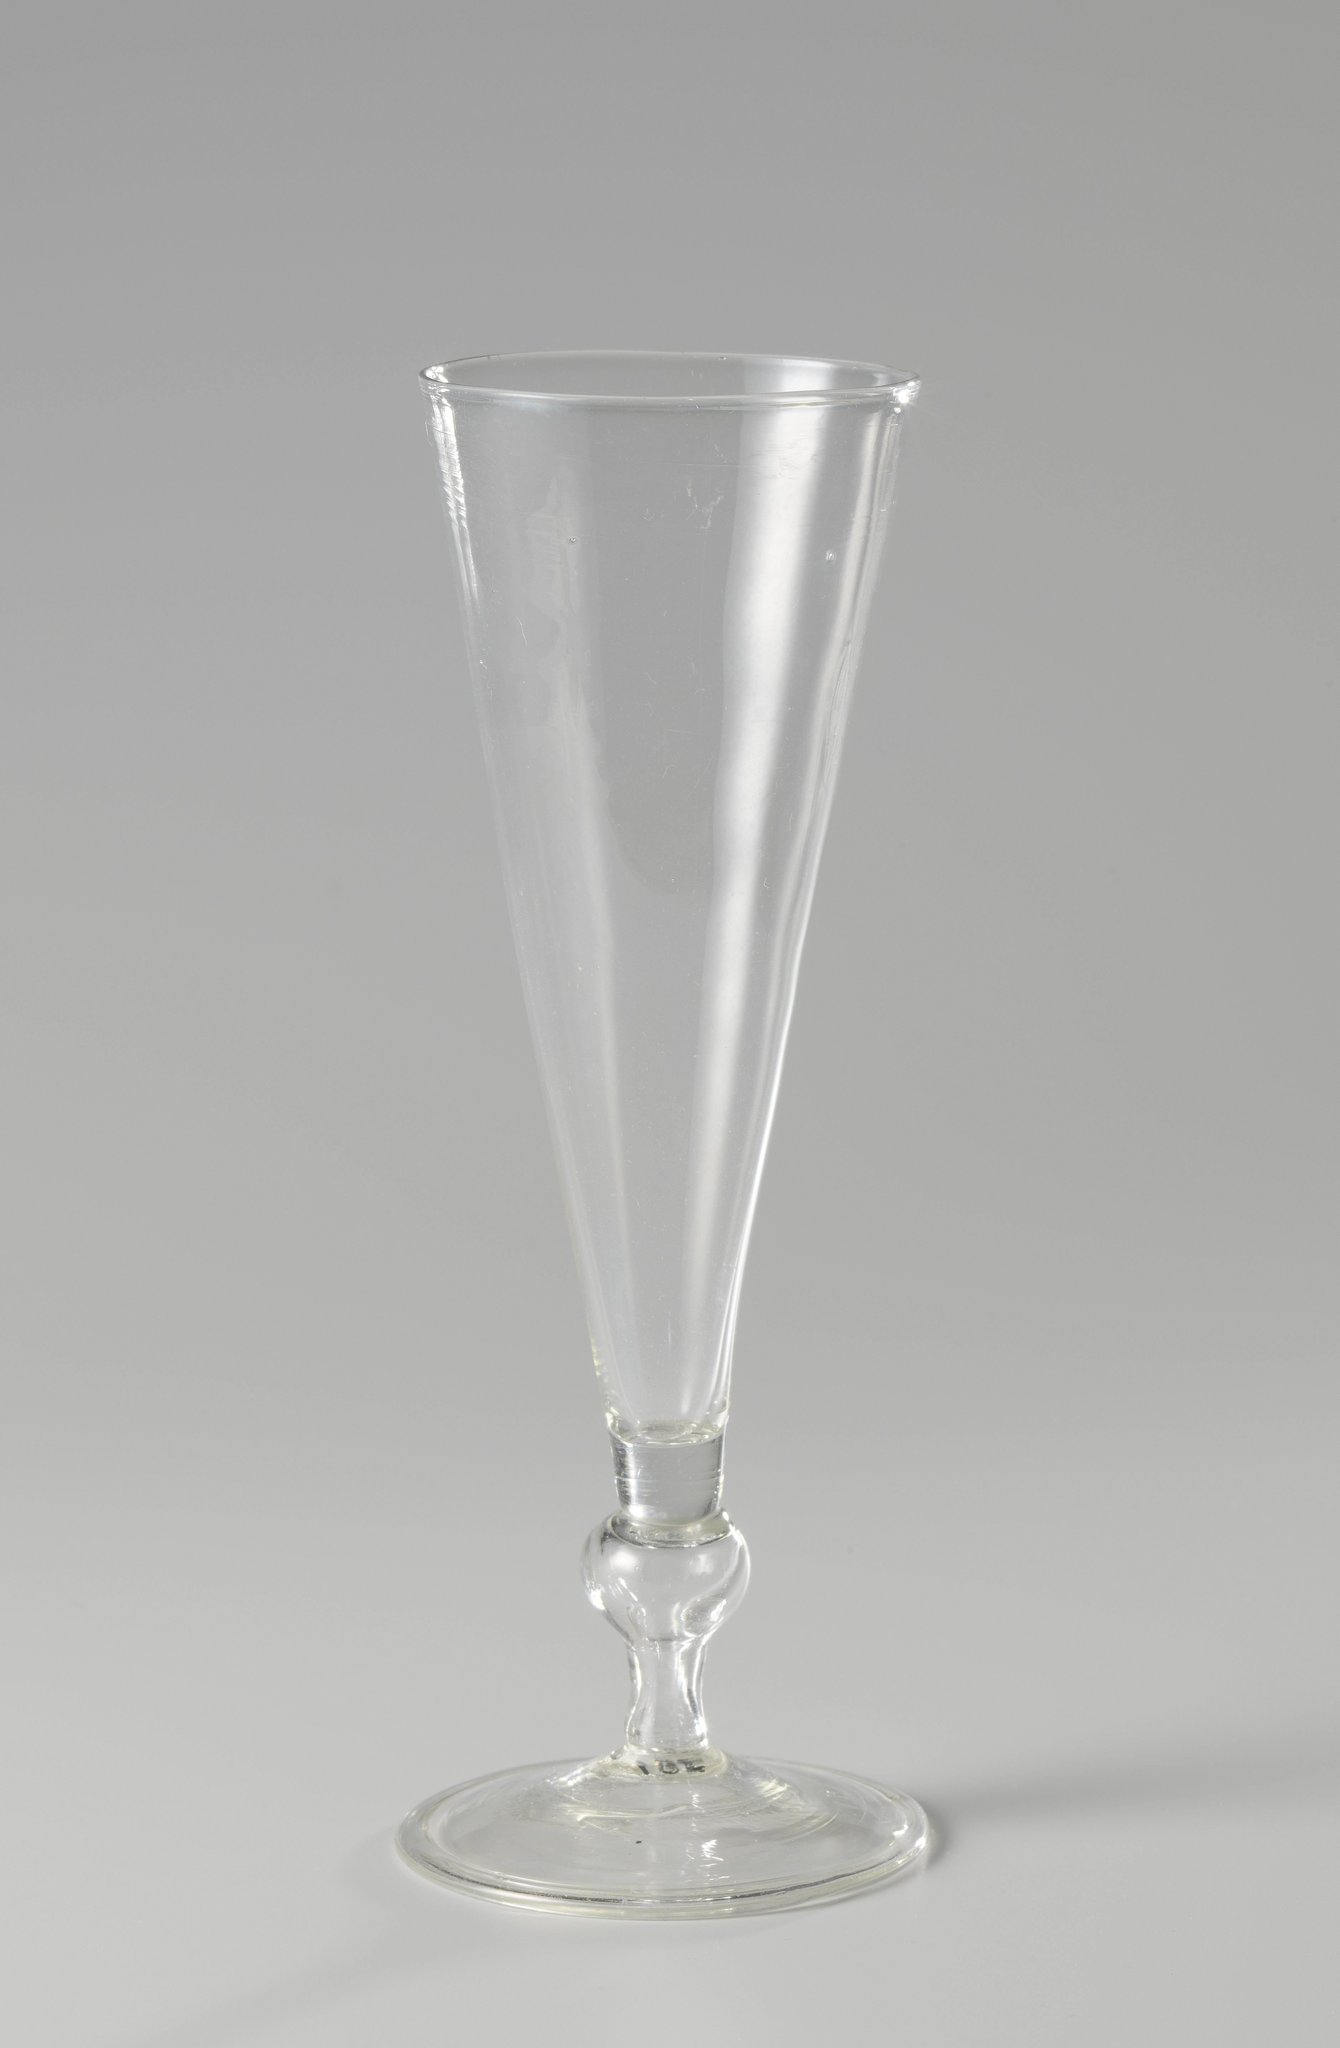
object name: flute glass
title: Fluitglas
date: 1600-1699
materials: glass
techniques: façon de venise, glassblowing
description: Fluitglas op platte voet met omgeslagen rand. Balustervormige stam. Trechtervormige kelk